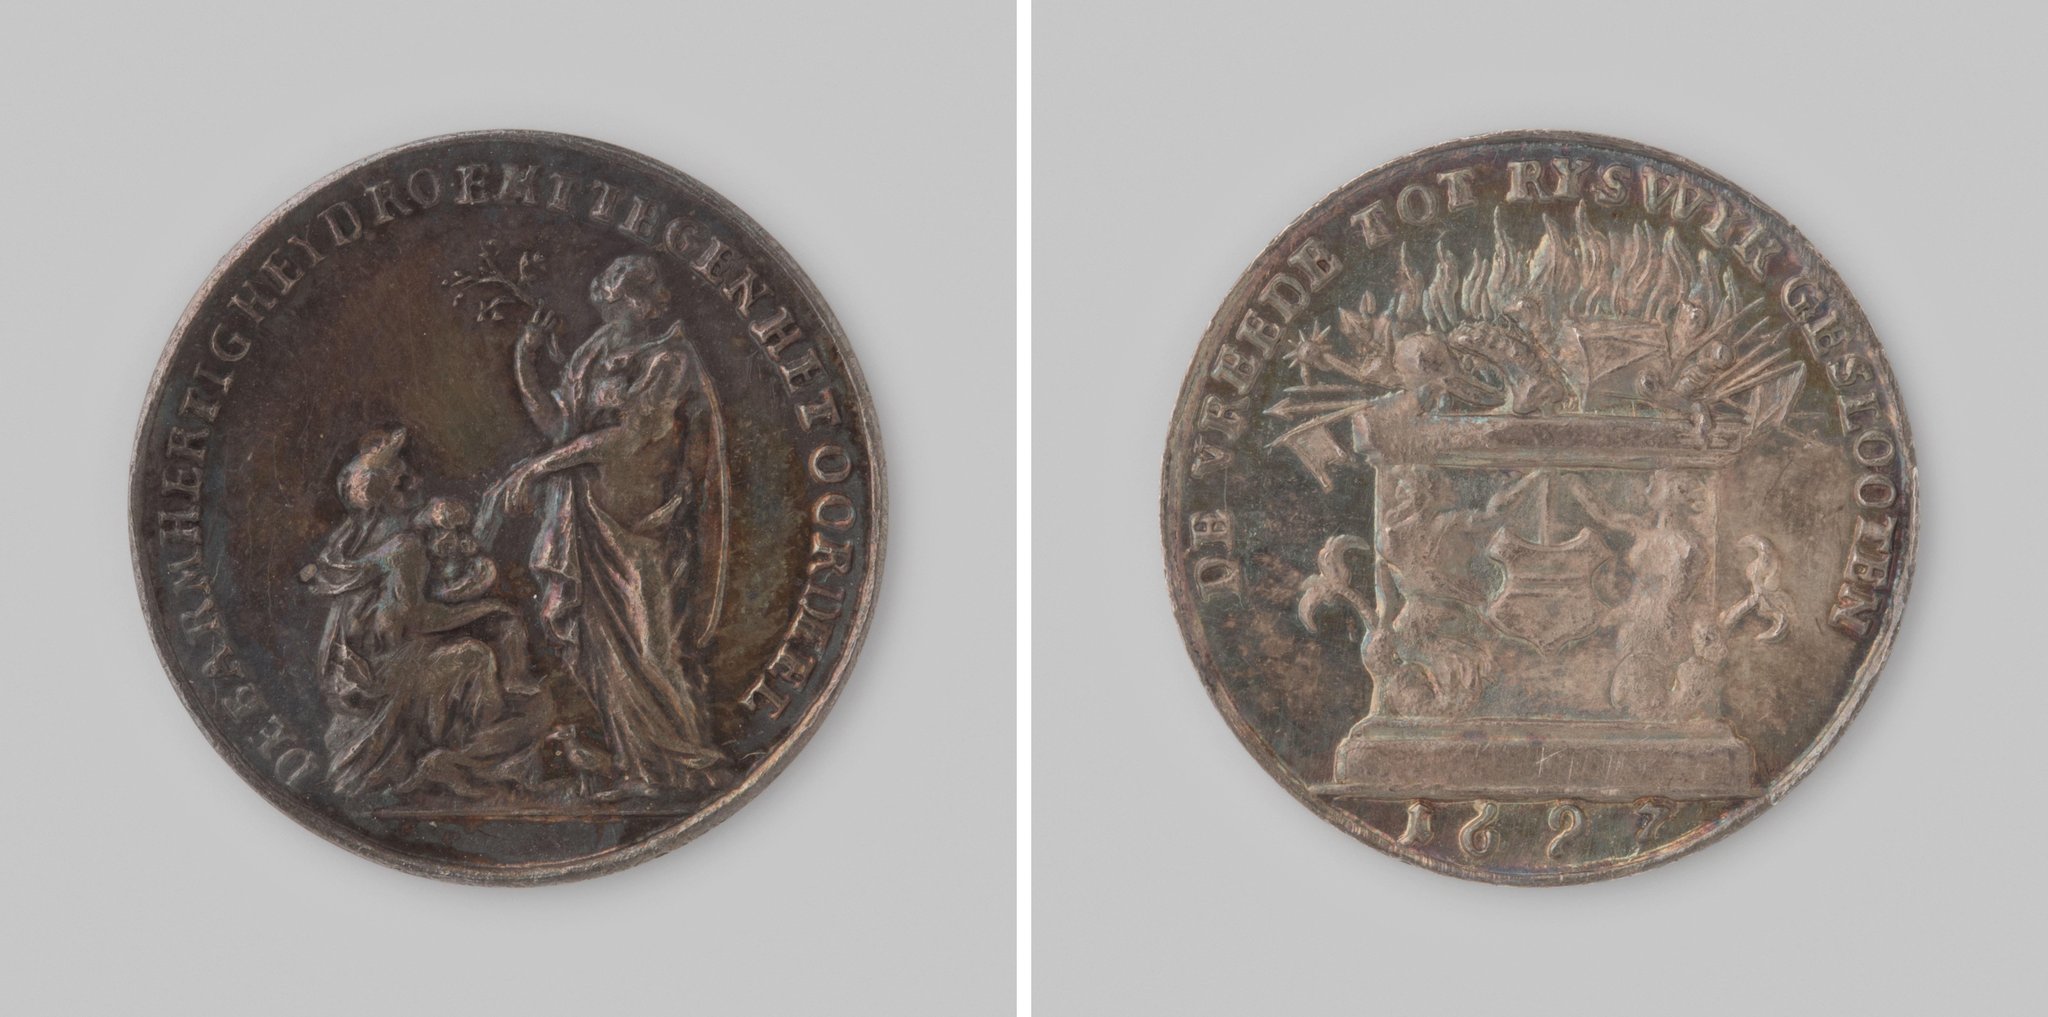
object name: history medal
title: Vrede van Rijswijk (Muidense loterij) 1697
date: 1697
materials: silver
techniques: striking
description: Zilveren penninkje, op de voorzijde de Barmhartigheid met vredestak die moeder met kind troost (in het midden een vogeltje), met omschrift, op de keerzijde een altaar, versierd met het wapen van Muiden, waarop oorlogstuig verbrand wordt, met omschrift.